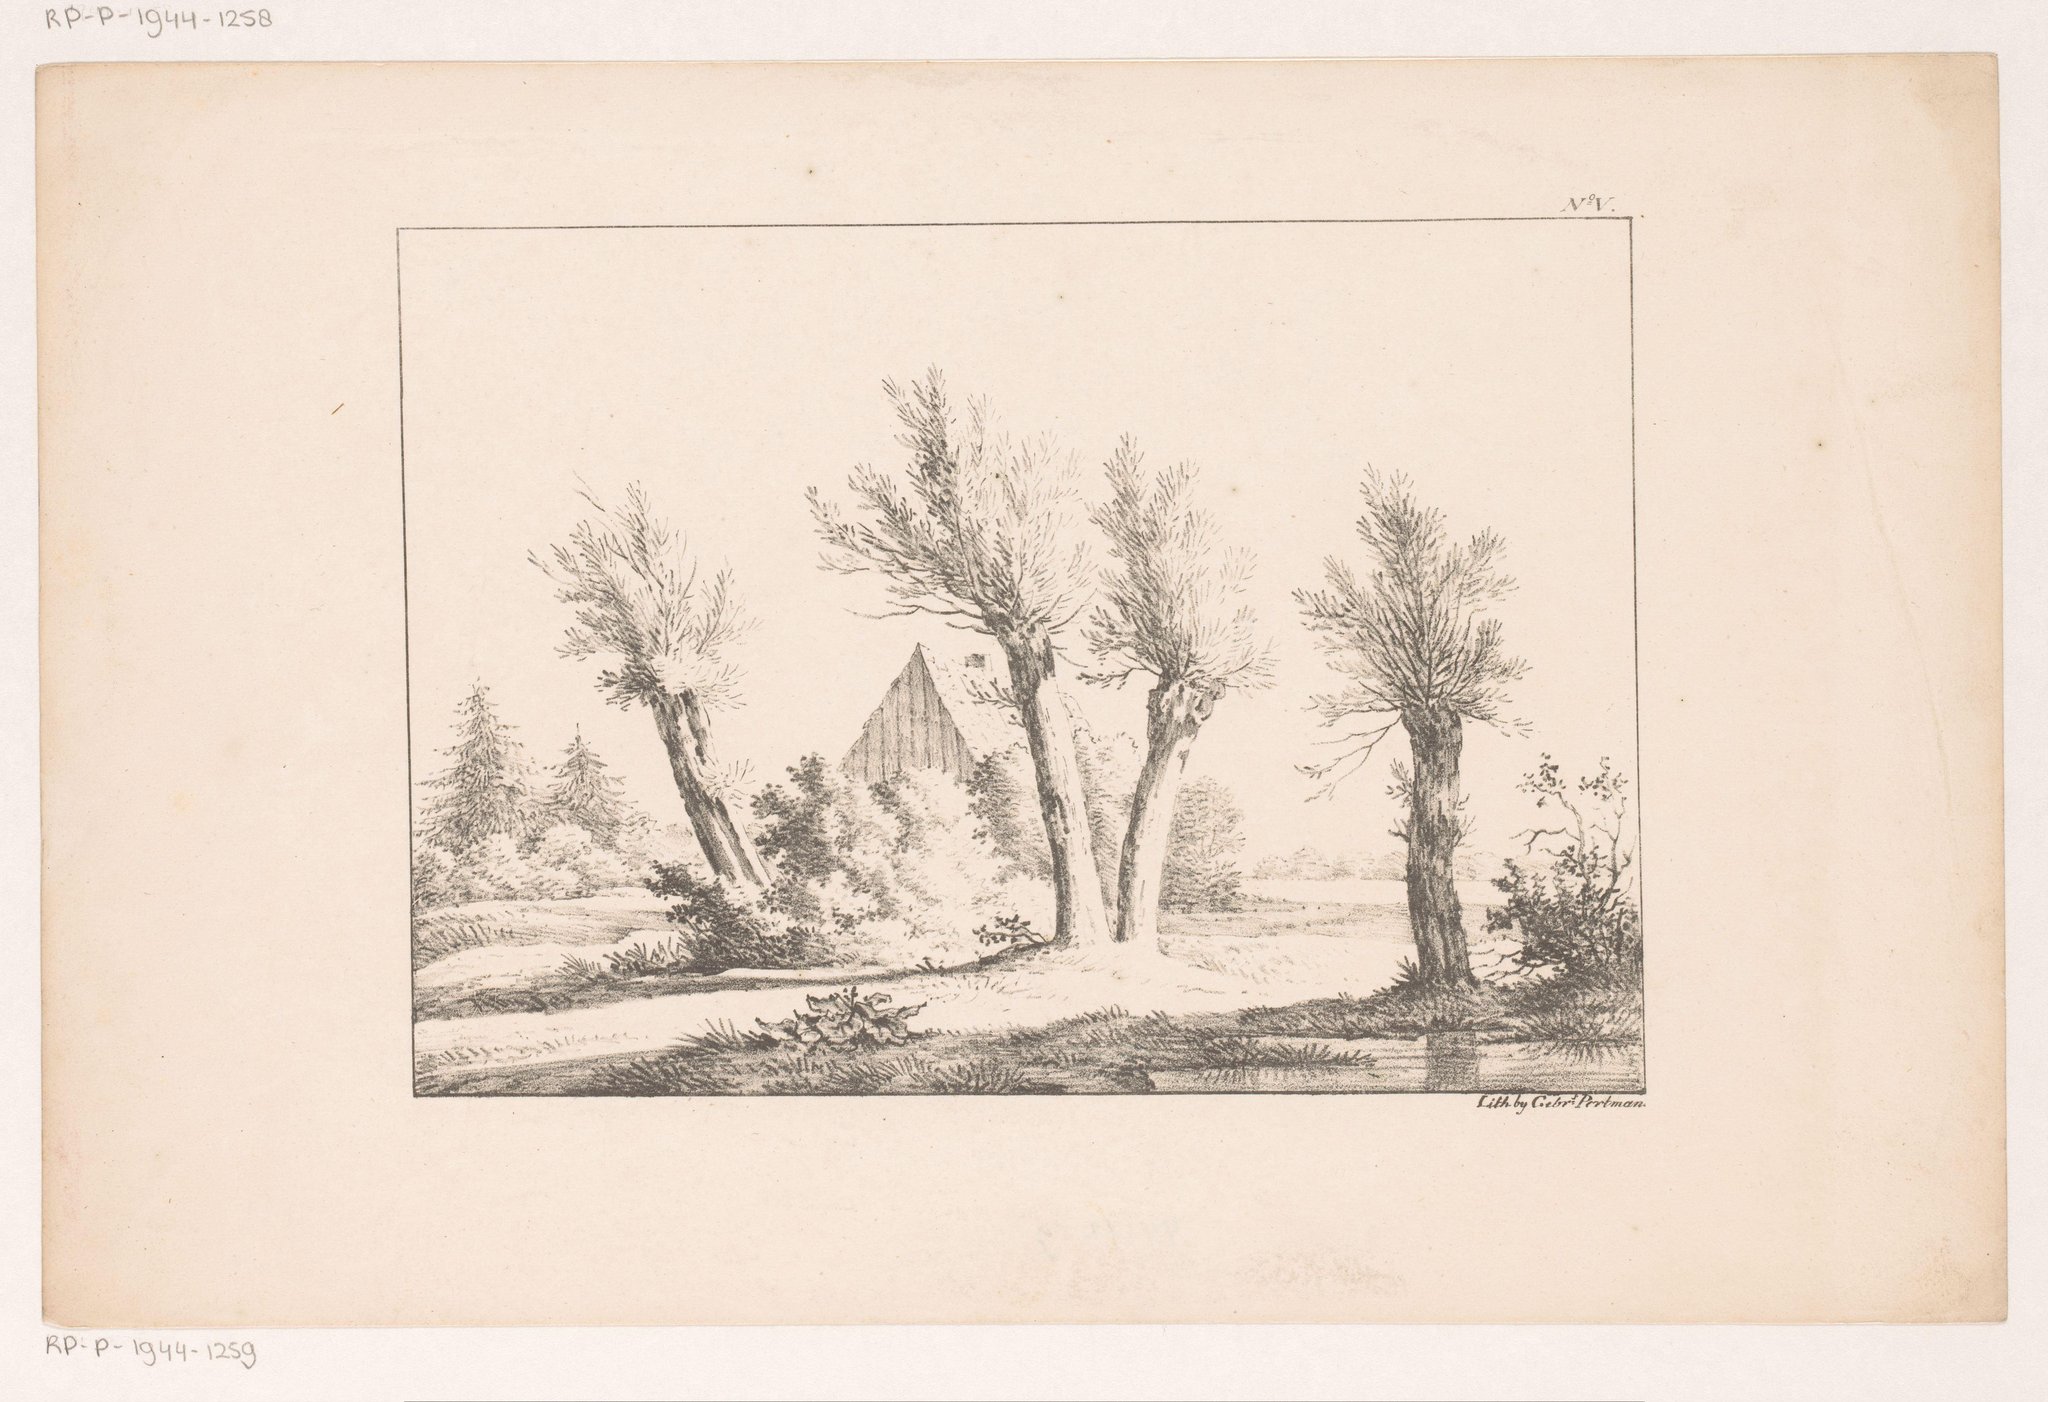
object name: print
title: Vier bomen voor huis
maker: Anonymous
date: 1827-1828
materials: paper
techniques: lithograph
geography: amsterdam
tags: trees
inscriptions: collector's mark: Lugt 2228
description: Een landschap met vier bomen voor een huis, rechtsvoor een plas.